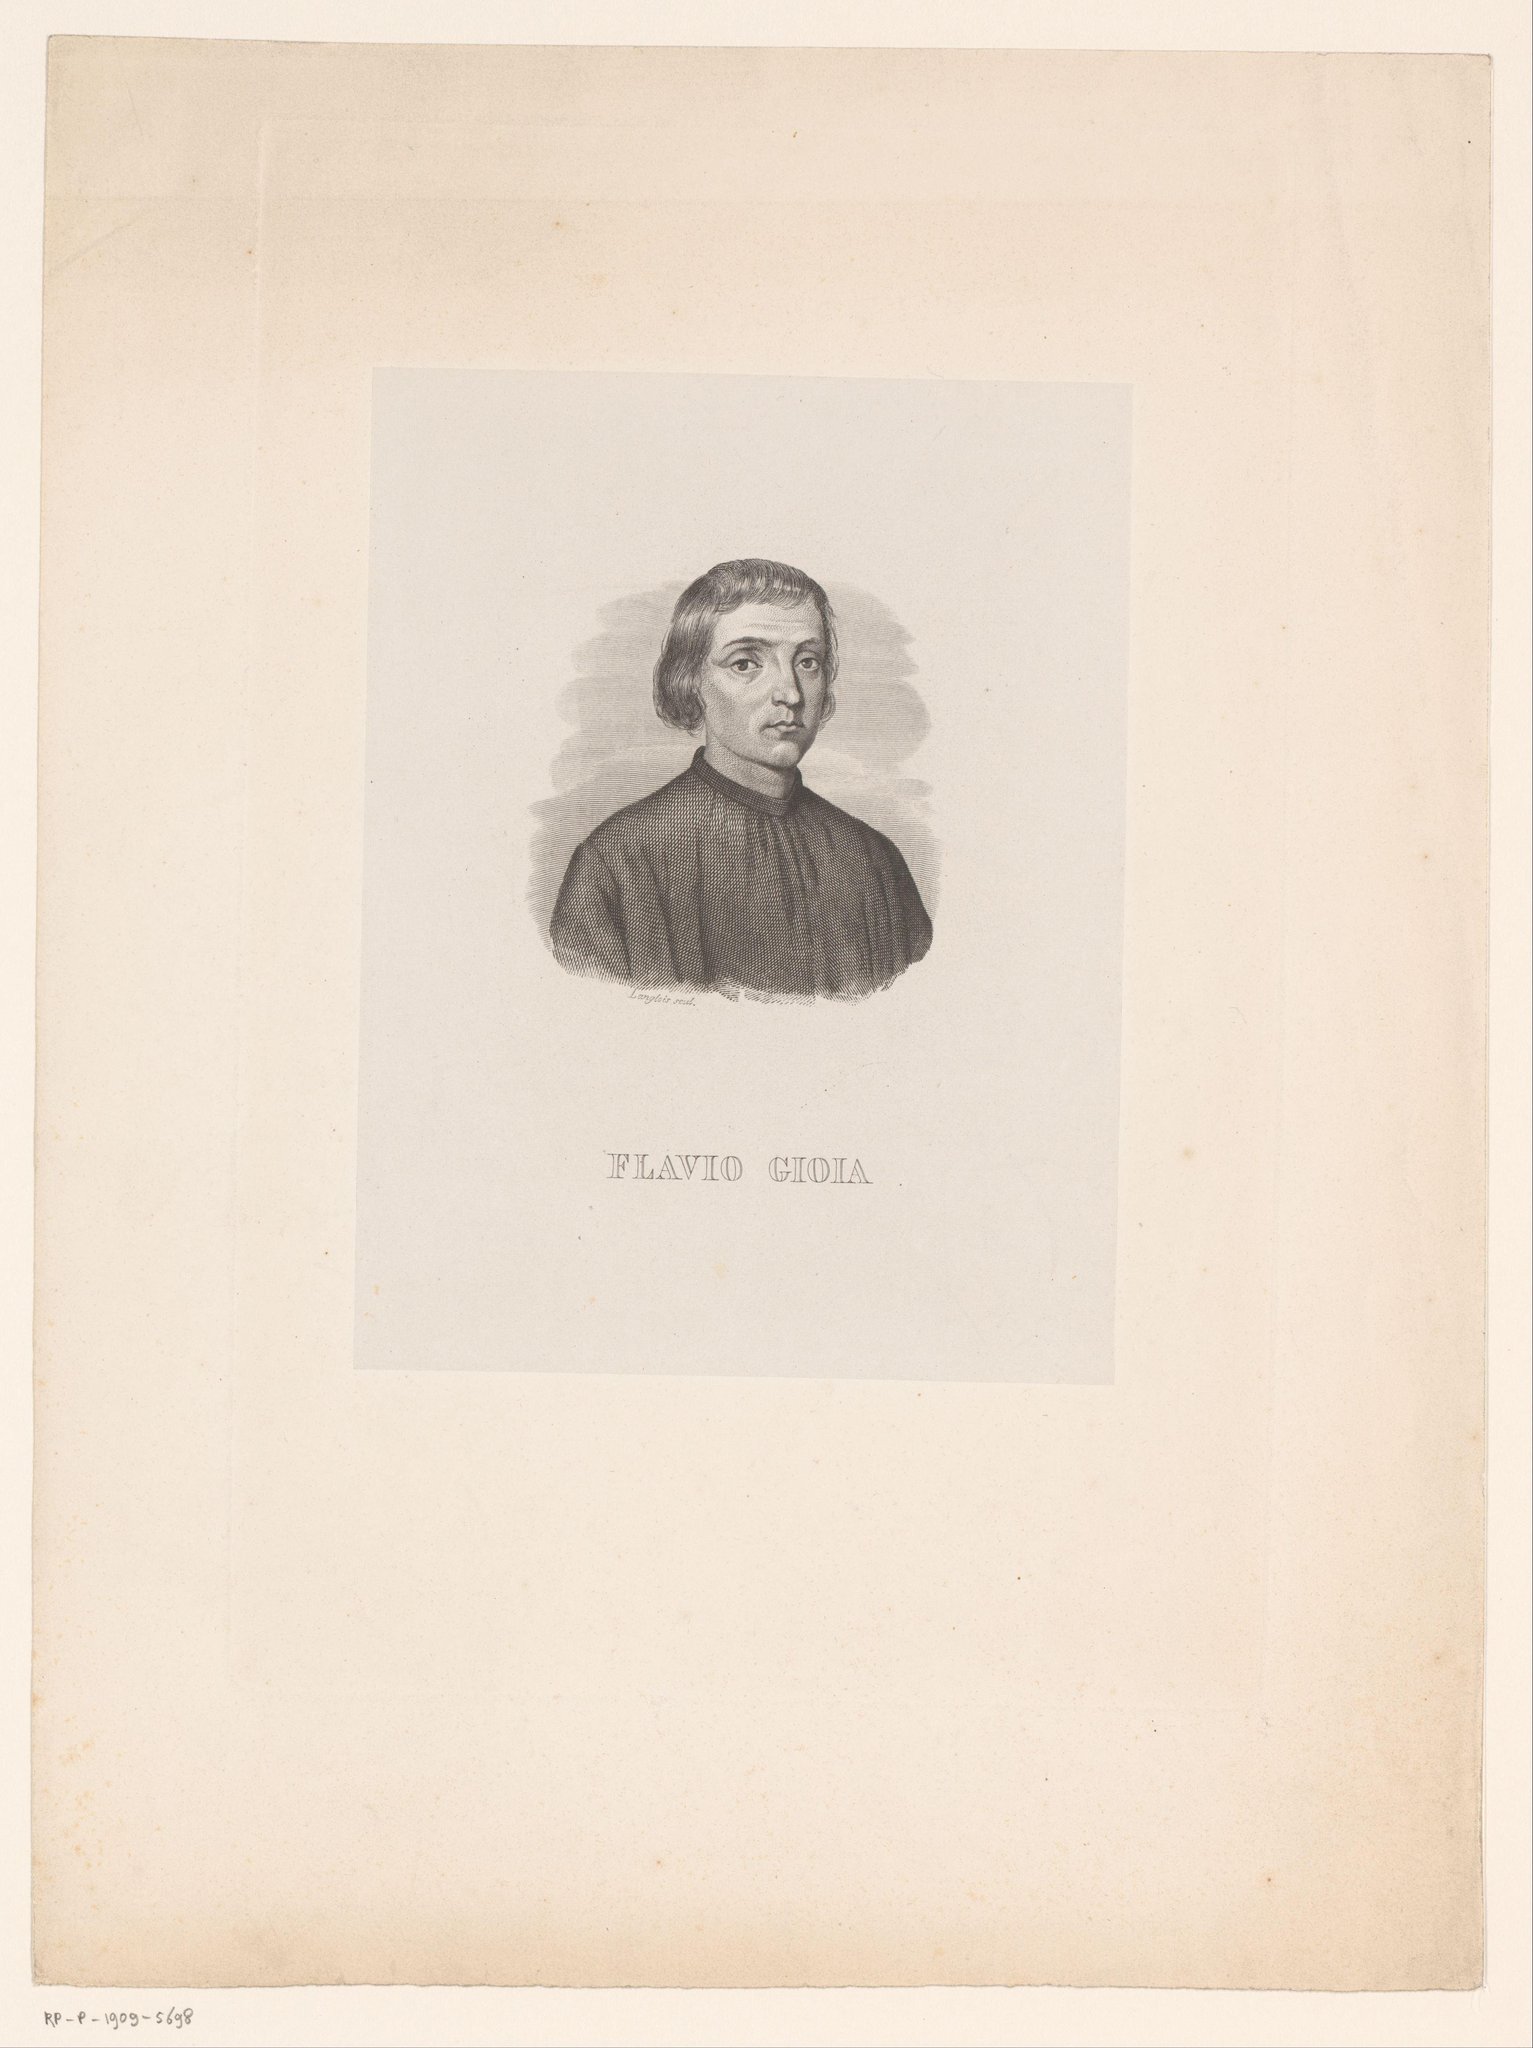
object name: print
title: Portret van Flavio Gioja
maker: pierre gabriel langlois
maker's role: print maker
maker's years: 1754-1810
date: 1764-1810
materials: paper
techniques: etching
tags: amalfi, historical persons, seaman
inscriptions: collector's mark: Lugt 2228